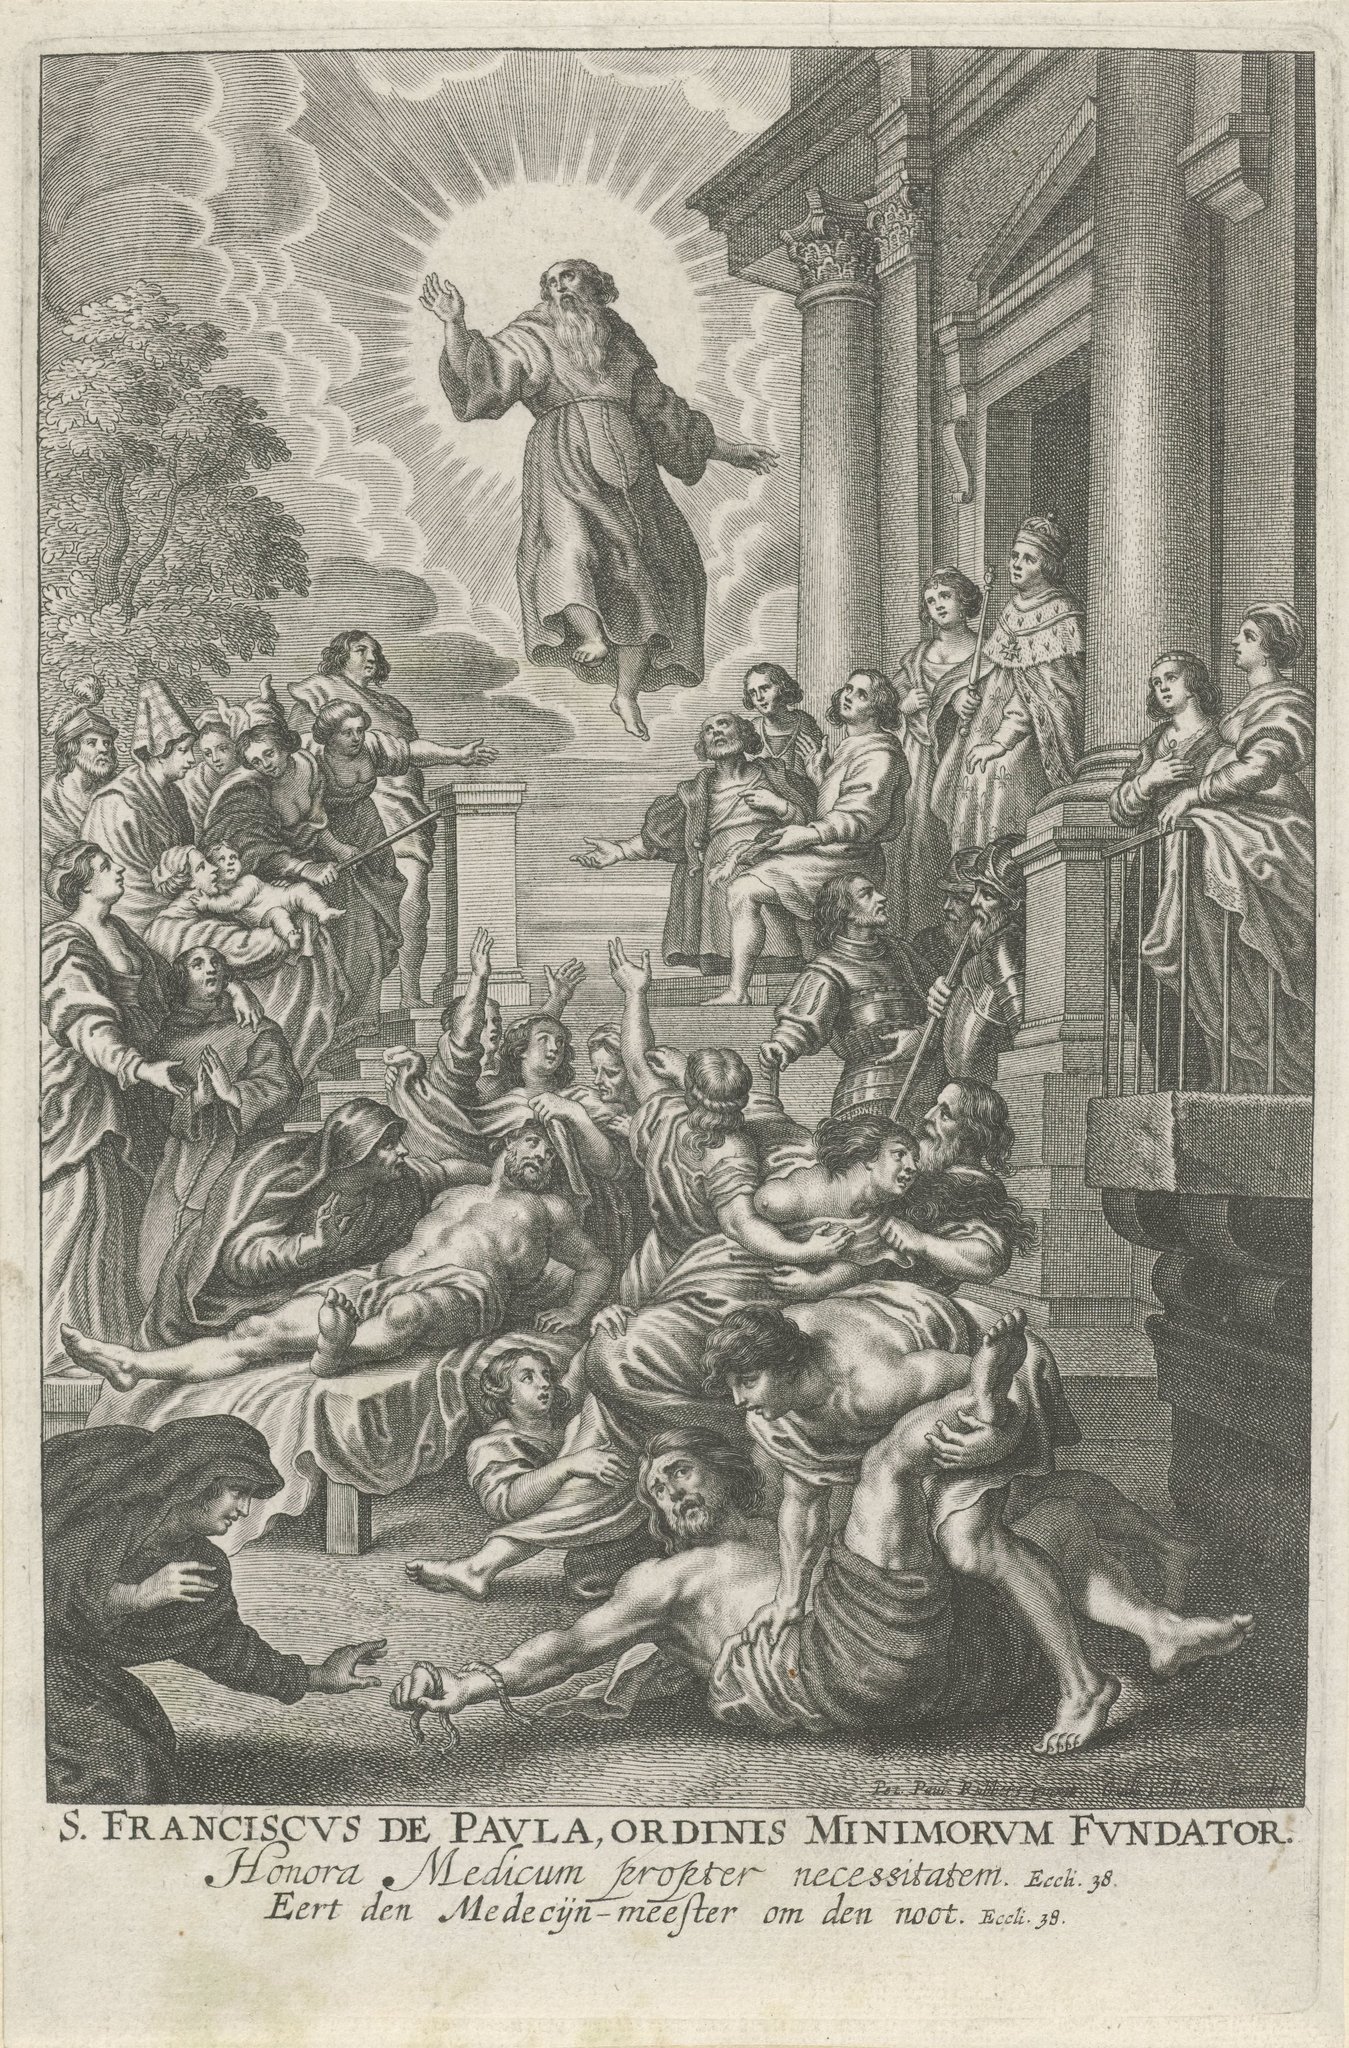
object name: print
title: H. Franciscus van Paola geneest de zieken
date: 1630-1651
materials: paper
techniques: engraving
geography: antwerp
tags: the hermit and founder of the (franciscan) minim friars, francis of paola; possible attributes: inscription 'charitas' on breast, discipline, skull, staff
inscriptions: collector's mark: Lugt 240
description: De heilige Franciscus van Paola, stichter van de Orde der Miniemen, is aan een groep mensen verschenen om de zieken onder hen te genezen. Rechts kijken een koning en koningin vanaf een bordes toe. In de marge een drieregelig onderschrift in Latijn en Nederlands.